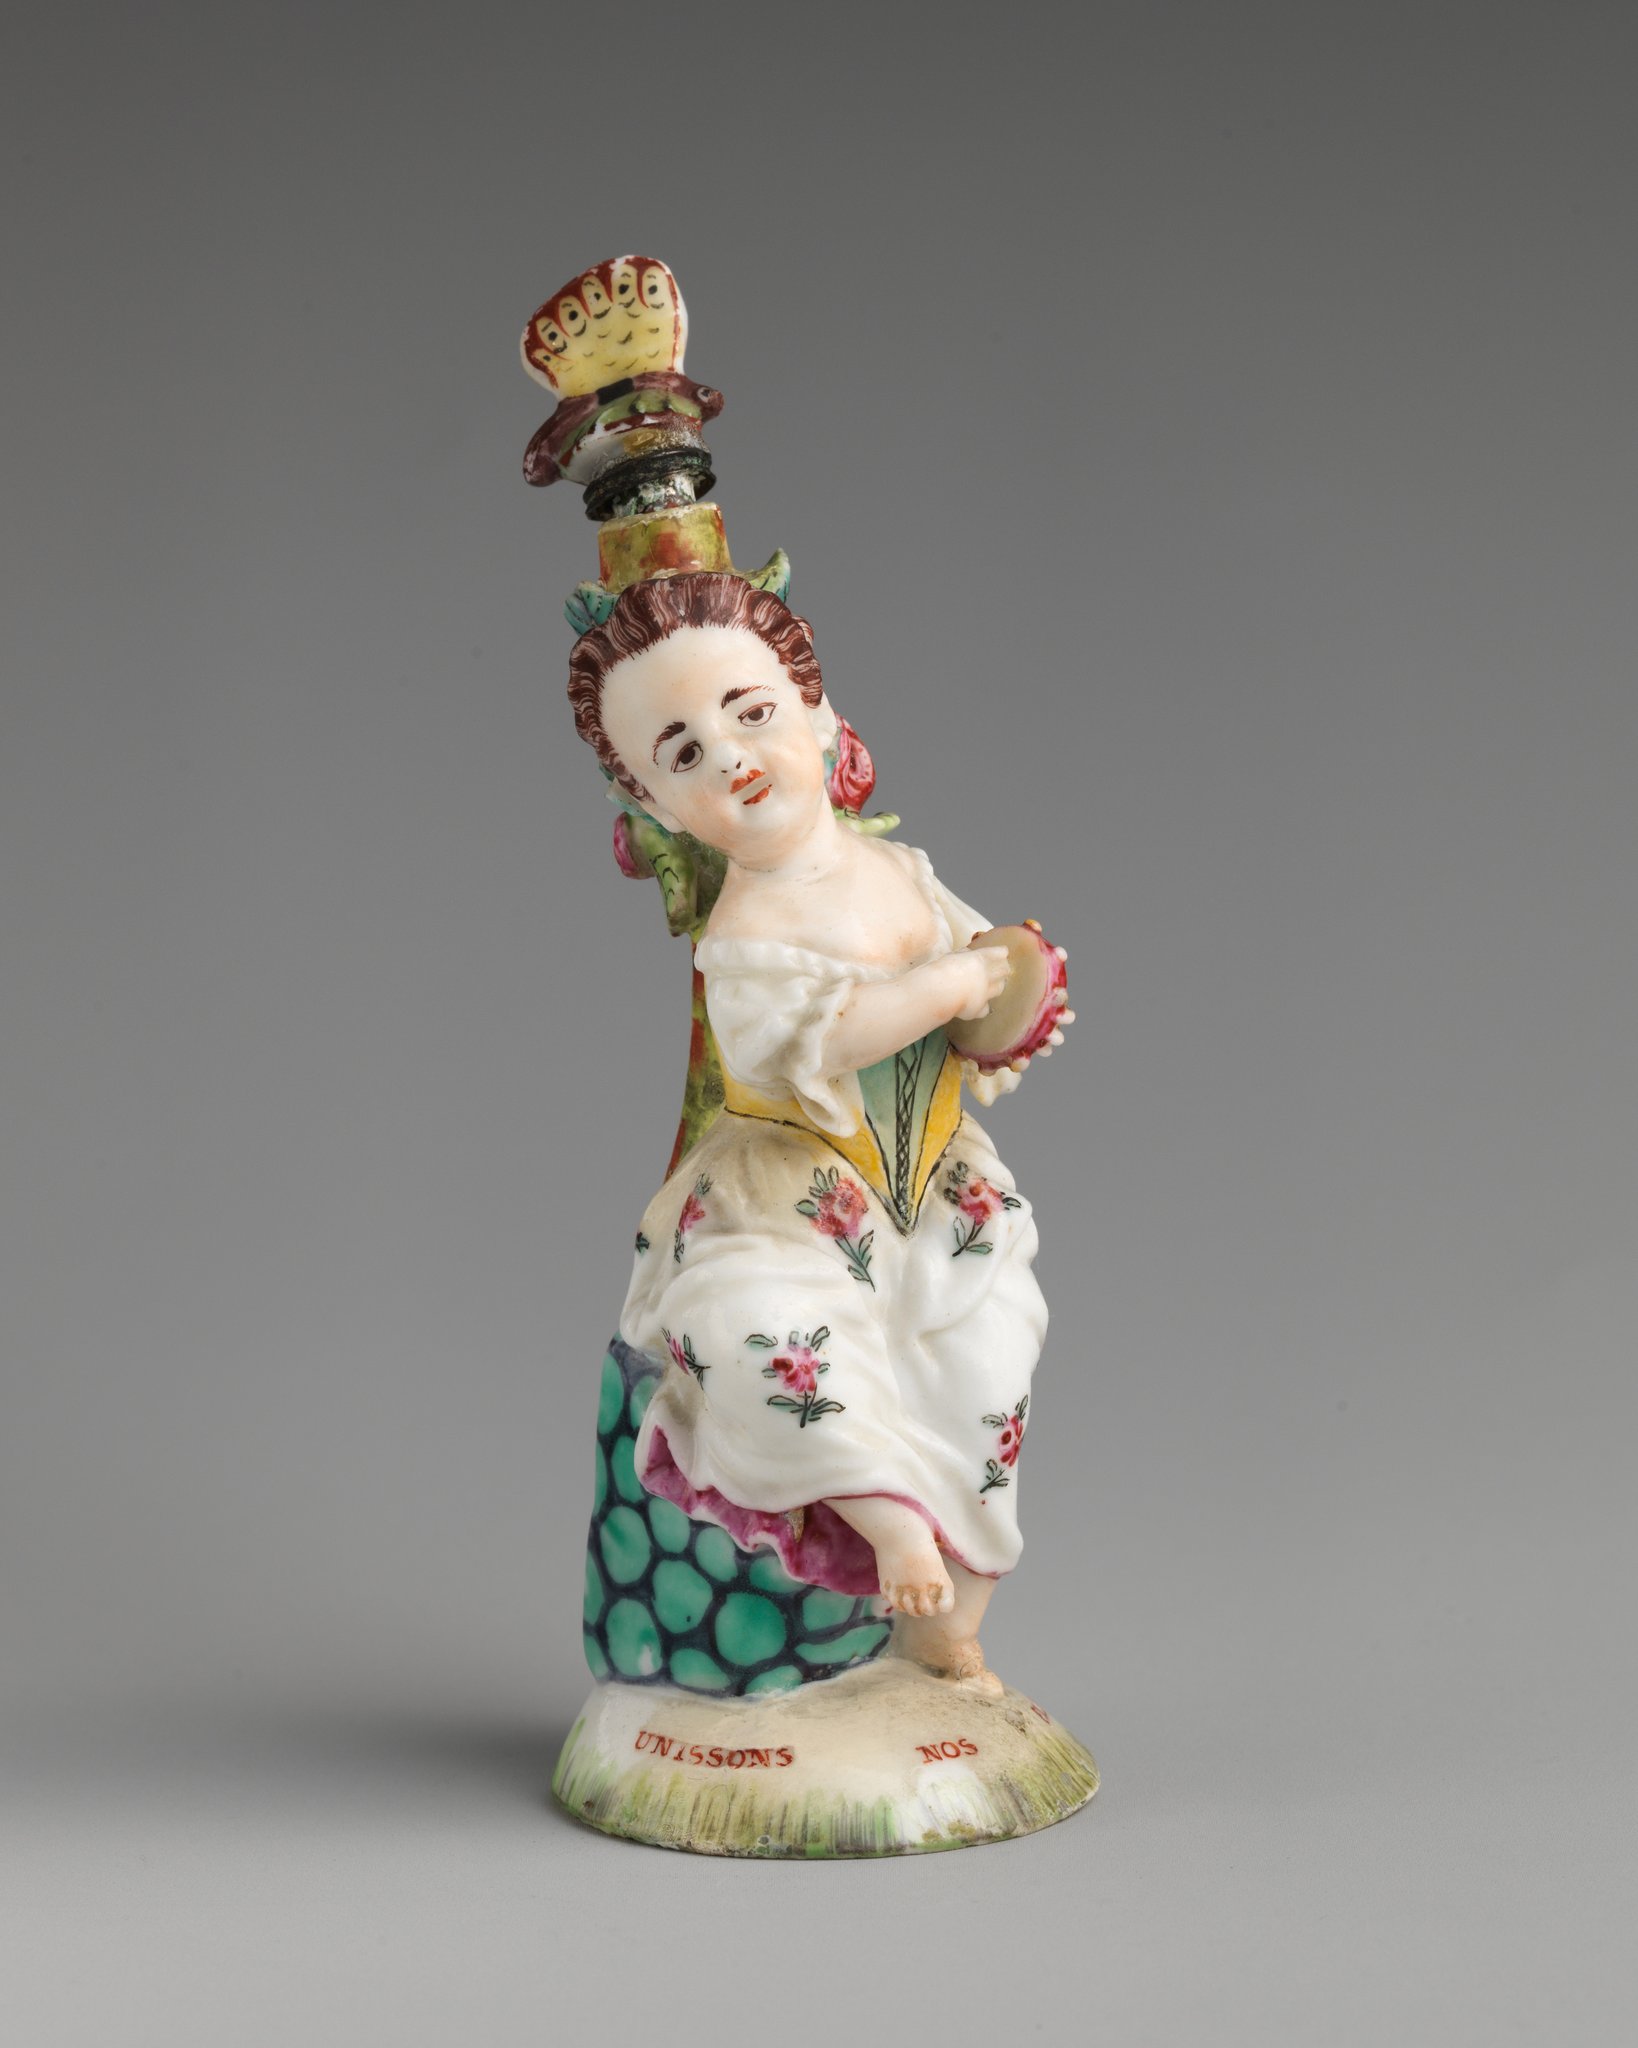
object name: toy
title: Girl with tambourine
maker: saint james's factory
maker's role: maker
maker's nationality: british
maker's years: 1749-1759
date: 1760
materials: soft paste porcelain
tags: musical instruments,girls